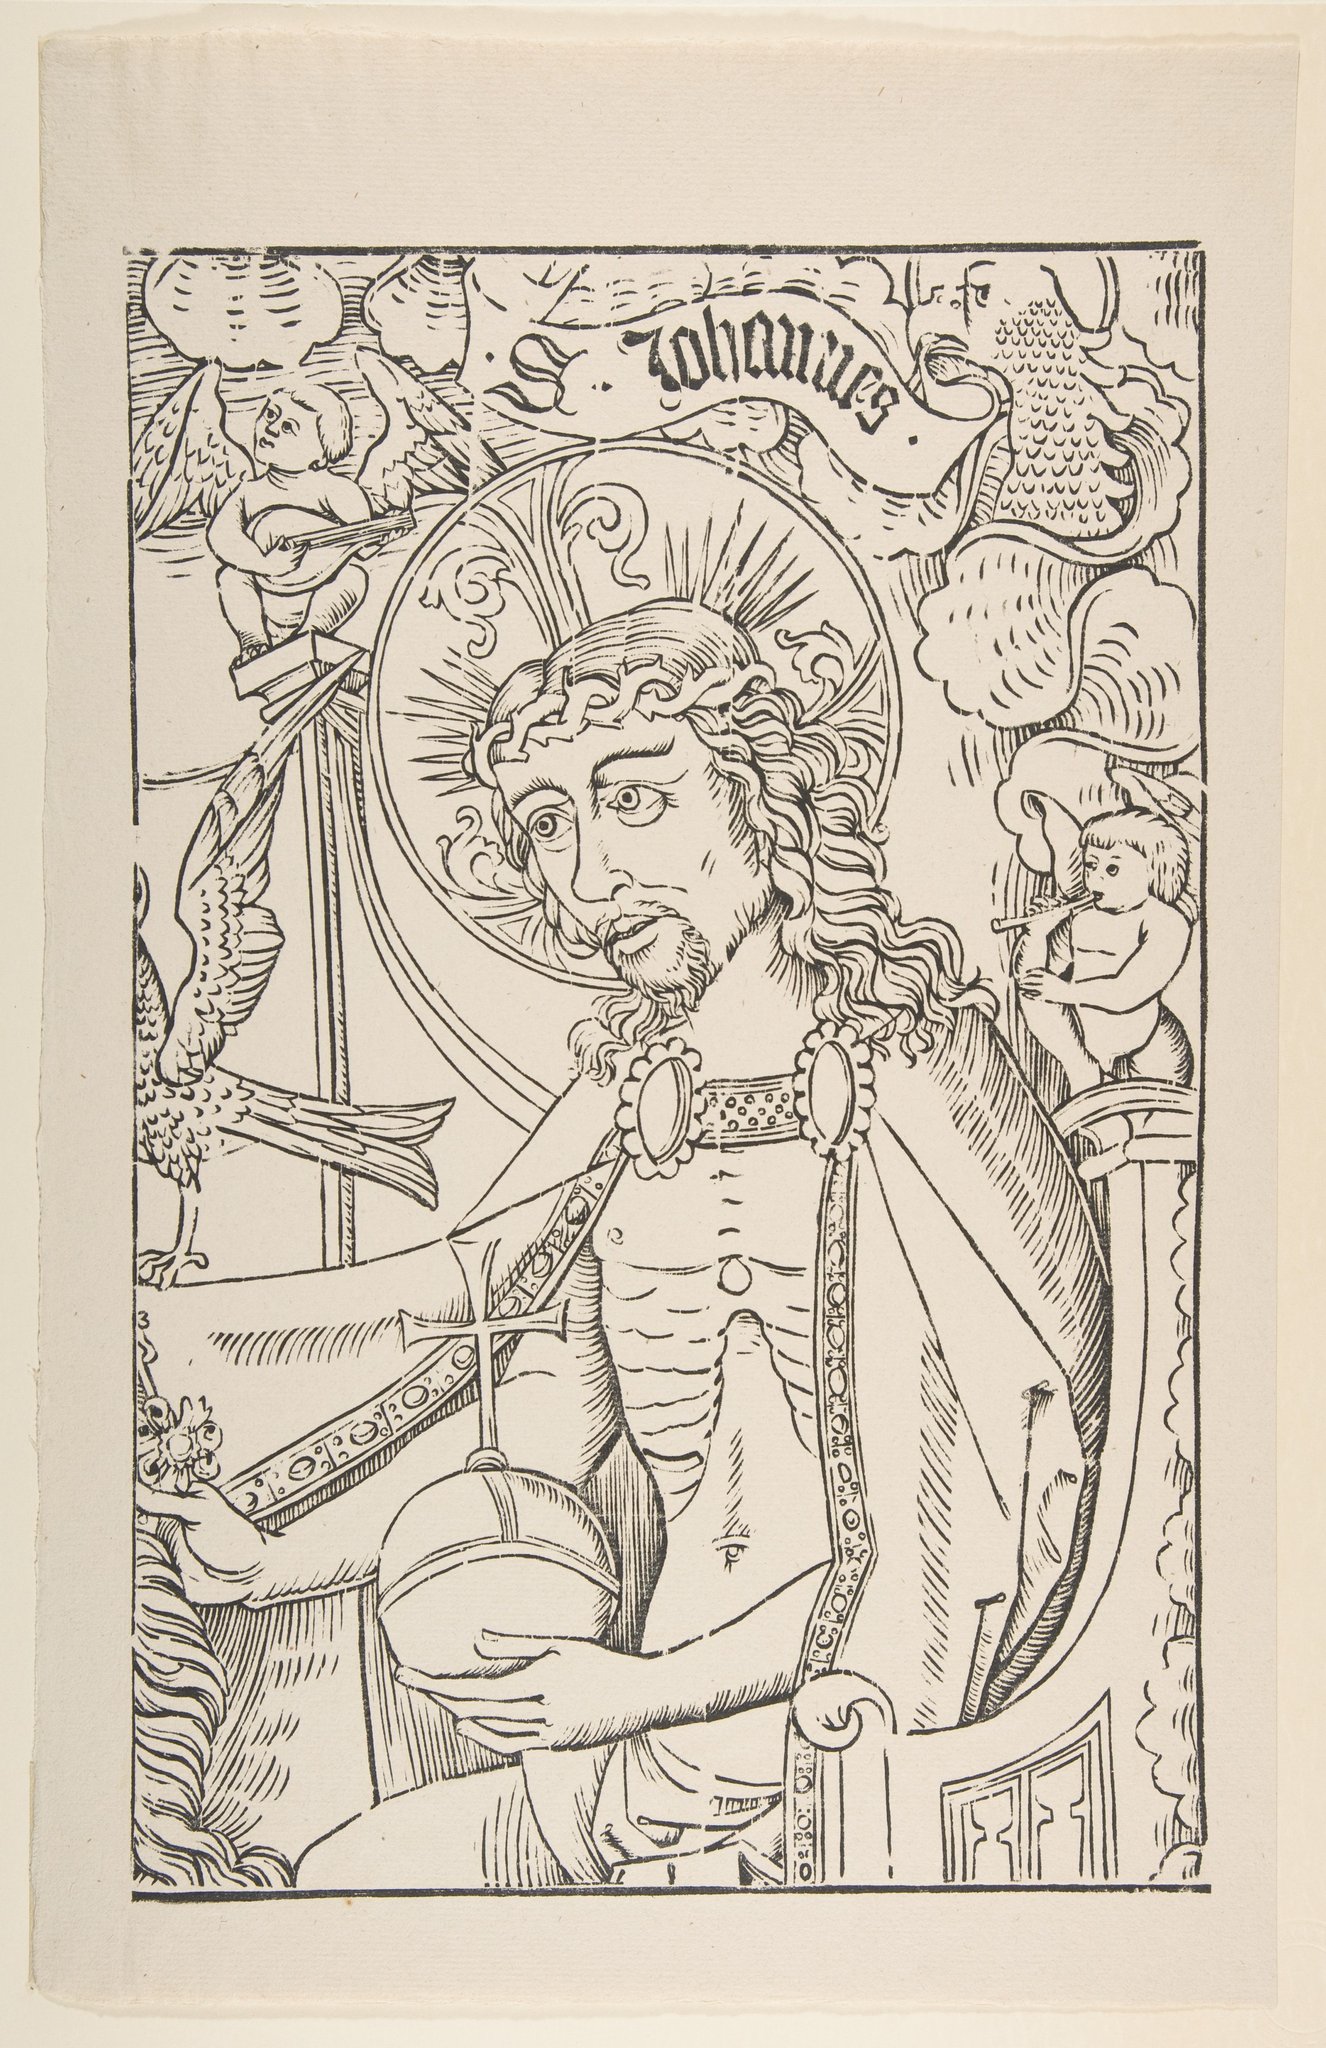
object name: print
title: Seated Christ Holding the Orb, a section of the "Crowning of the Virgin"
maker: anonymous, 15th century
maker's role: artist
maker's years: 1400-1500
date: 1401-1500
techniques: woodcut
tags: musical instruments,cupid,cross,jesus